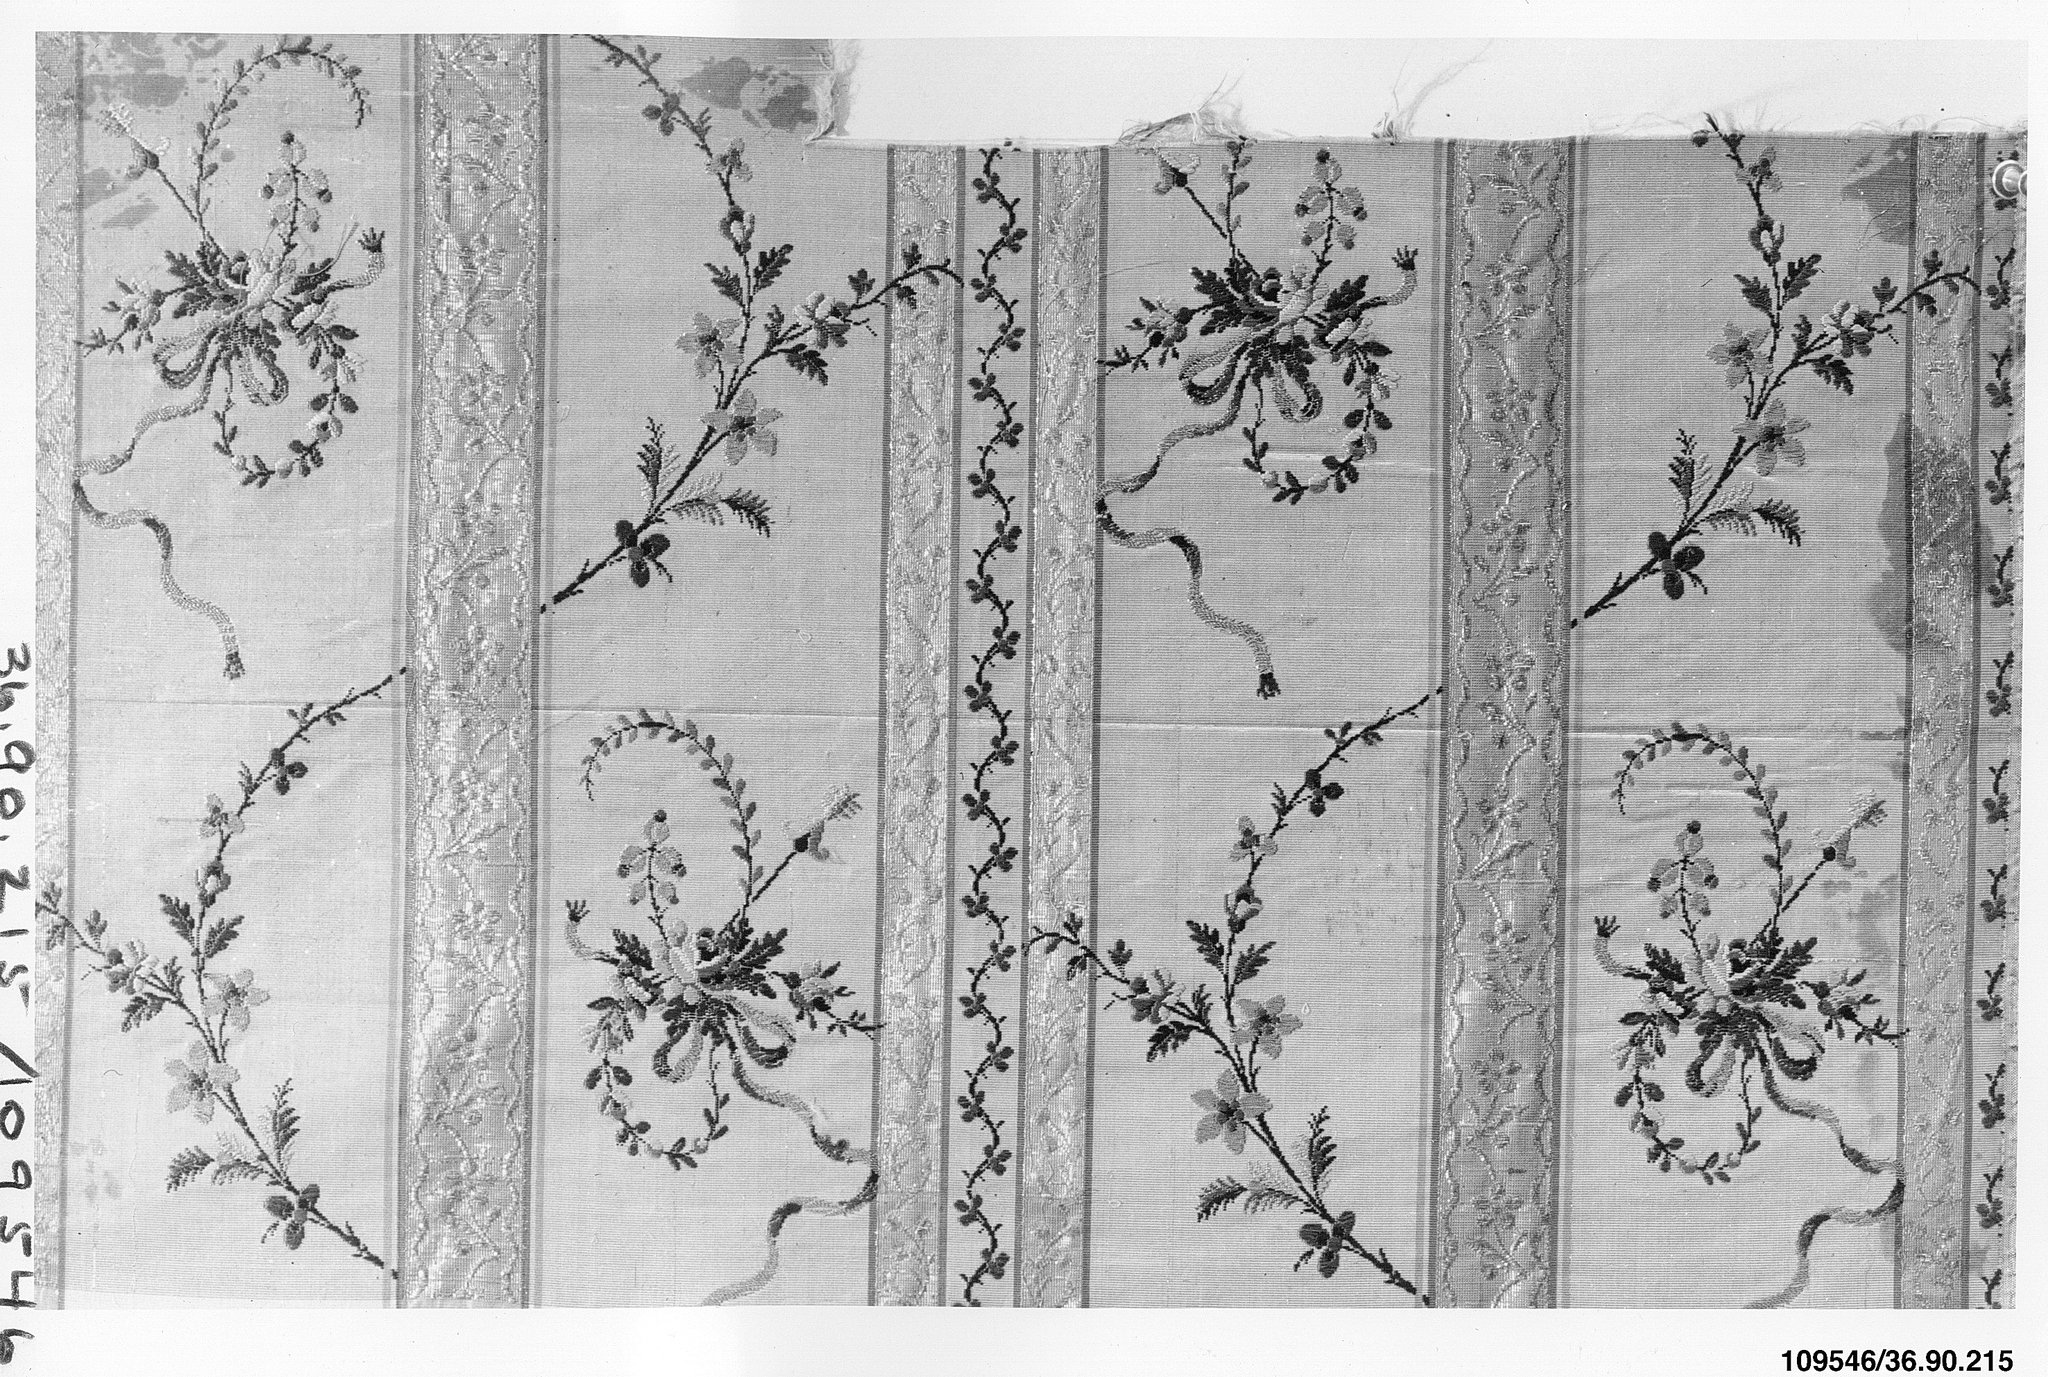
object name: piece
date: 1701-1800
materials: metal thread, silk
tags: flowers,leaves